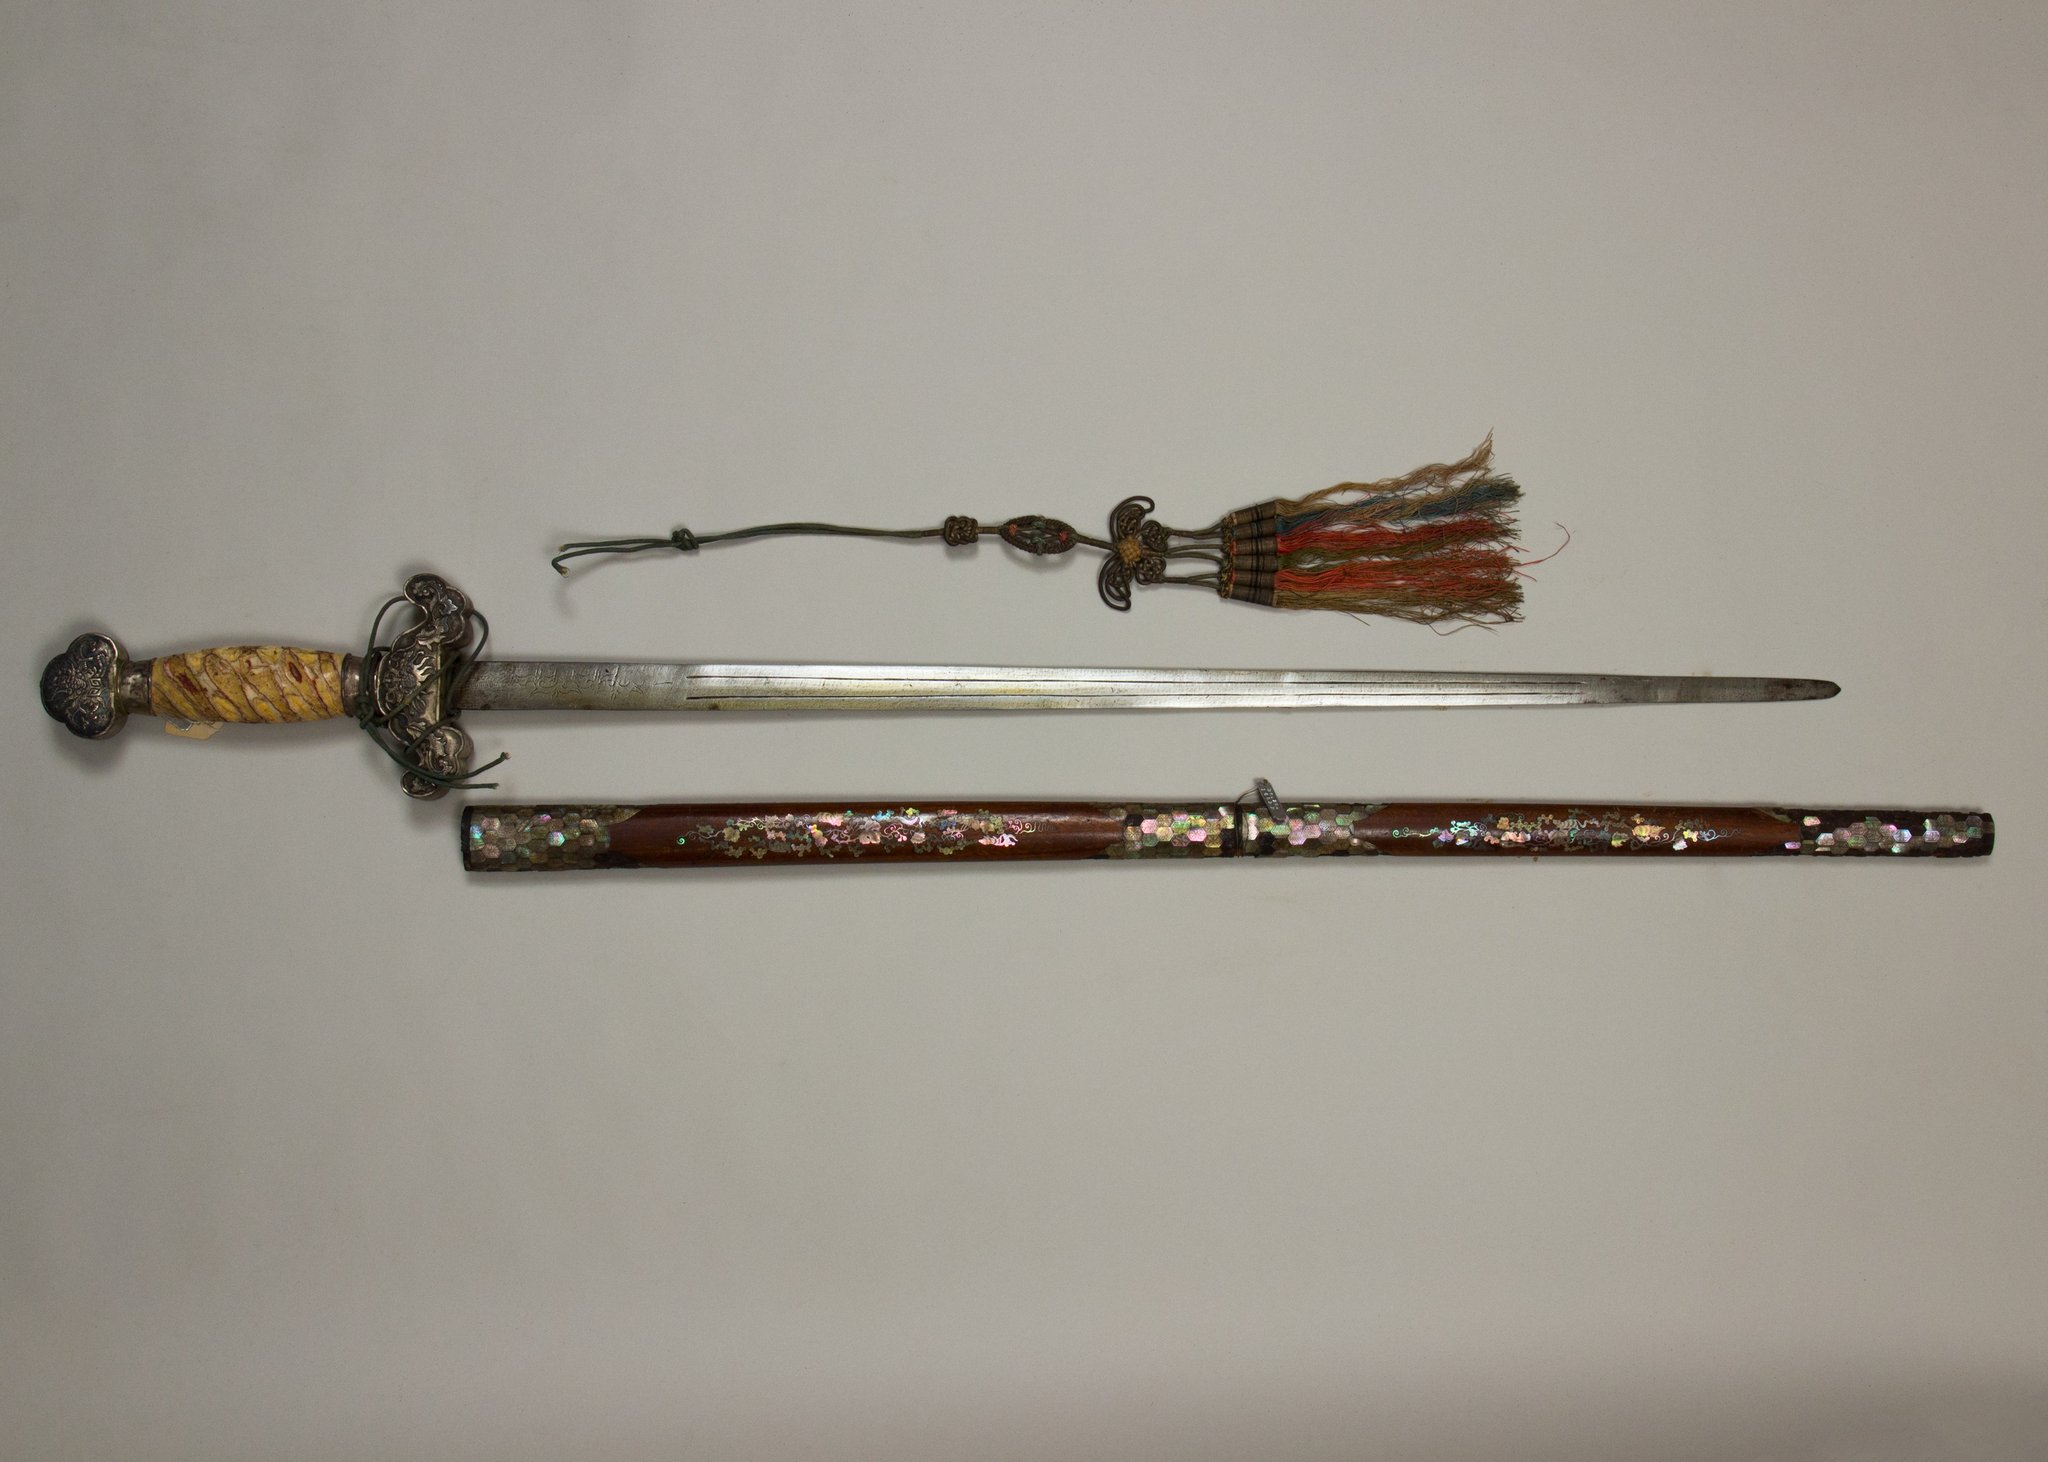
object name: sword with scabbard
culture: indo-chinese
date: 1701-1900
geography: india